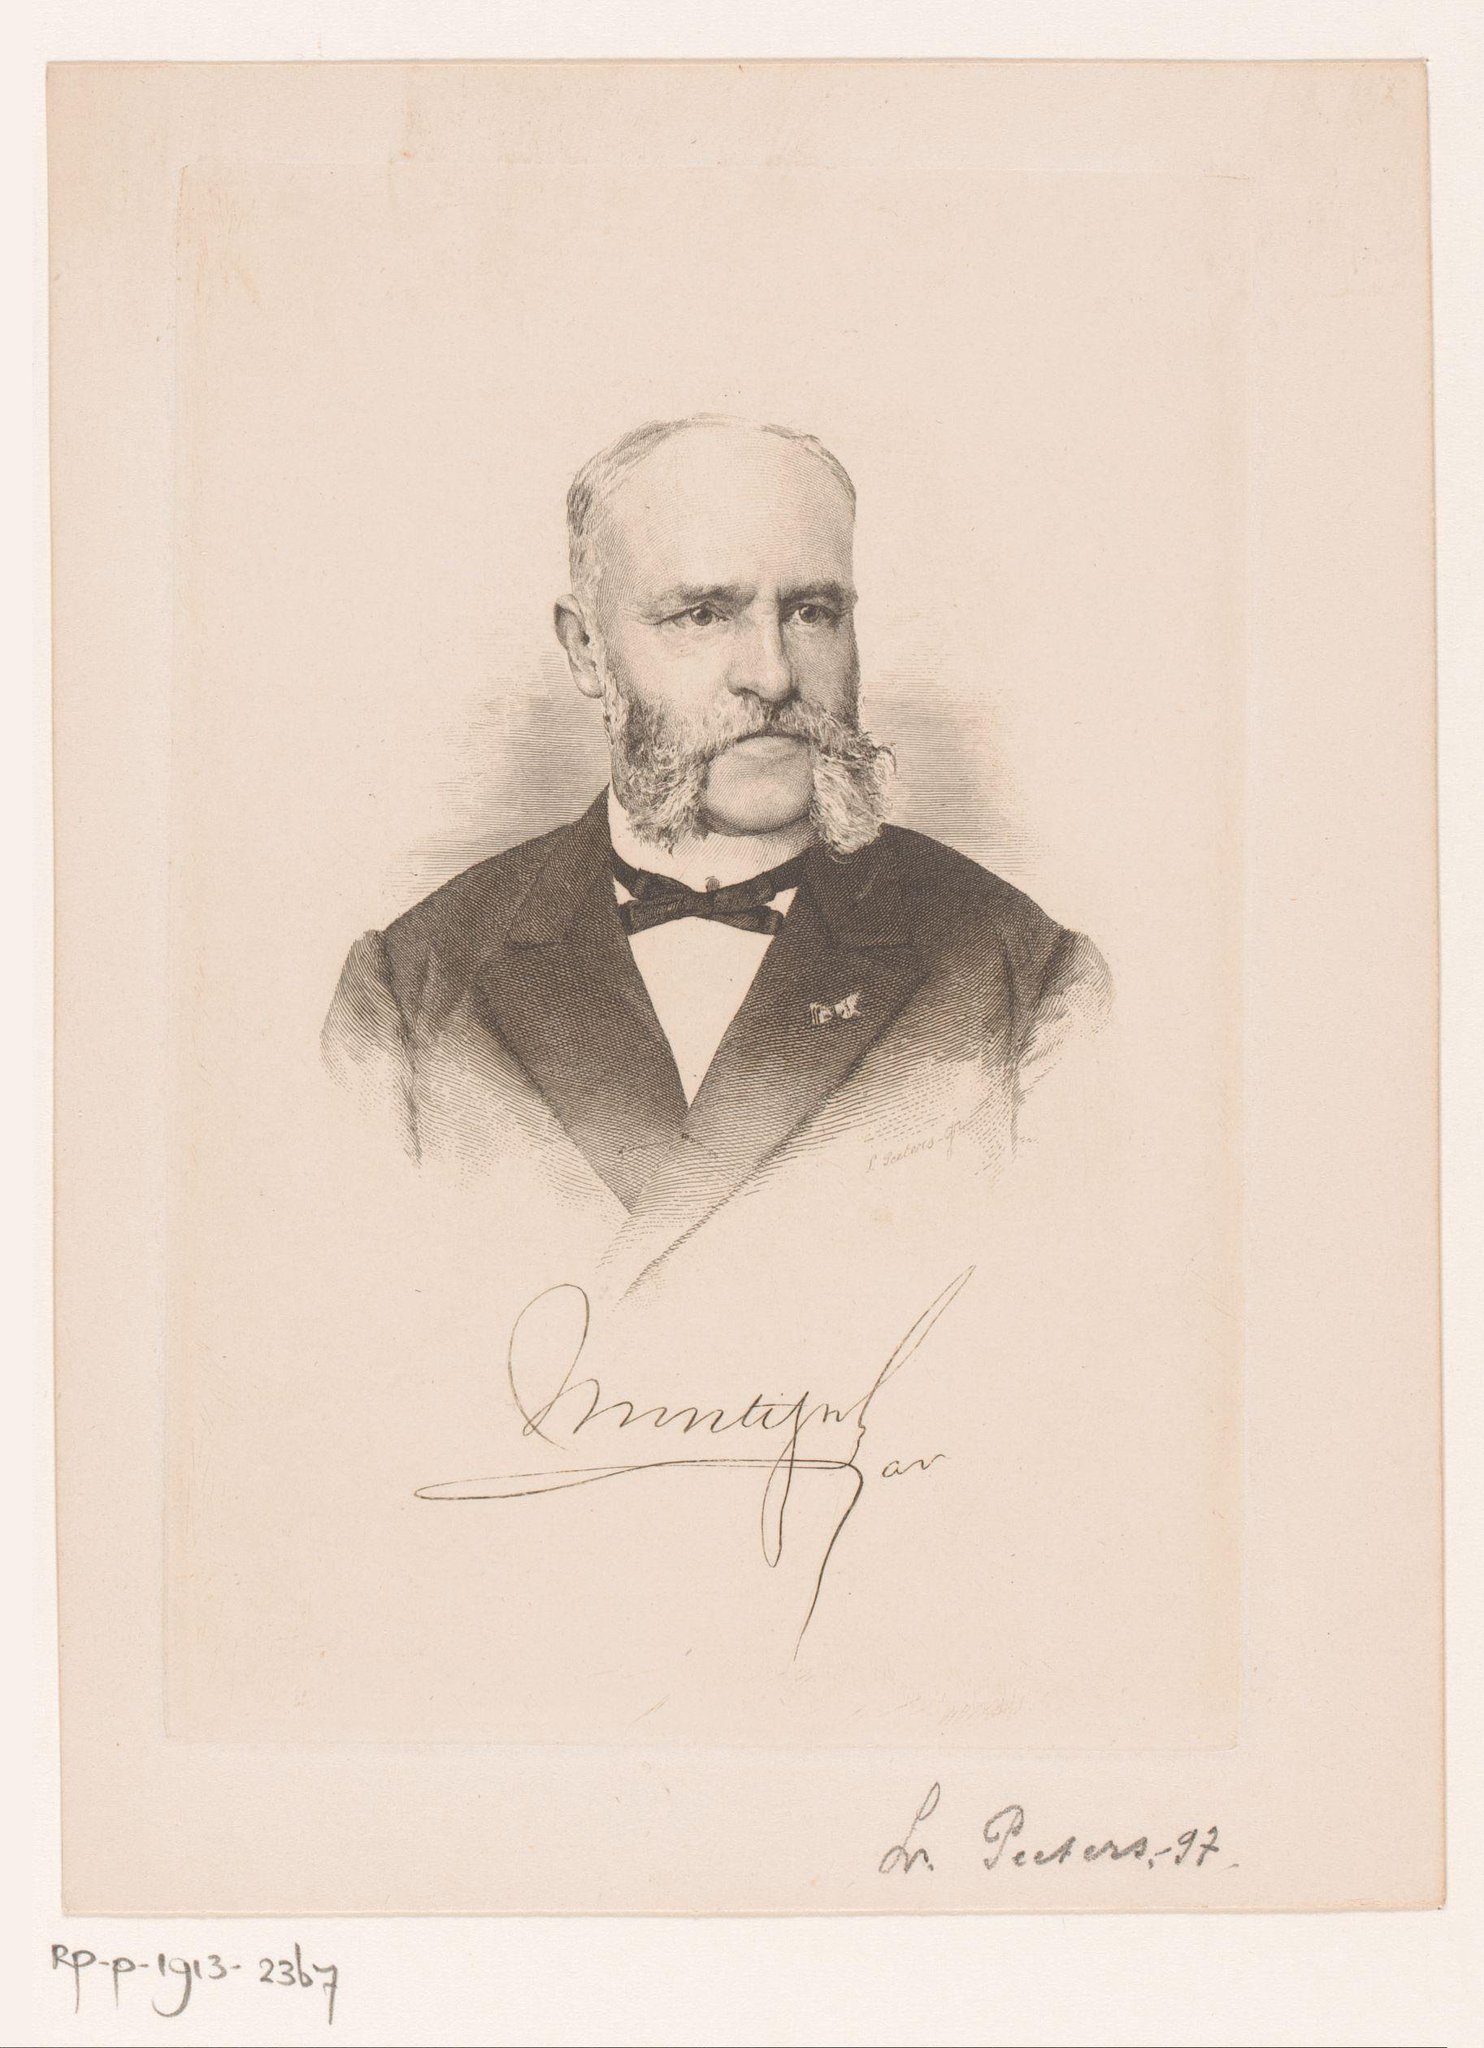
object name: print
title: Portret van een onbekende man, mogelijk Montigny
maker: louis peeters (i)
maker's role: print maker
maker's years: 1876-1964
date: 1897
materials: paper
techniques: etching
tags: anonymous historical person portrayed alone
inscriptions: collector's mark: Lugt 2228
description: Geboorte- en sterfdatum van de prentmaker zijn onbekend. Daarom is voor de bepaling van de rechten van dit object gebruik gemaakt van de verwervingsdatum Rijksmuseum Amsterdam.